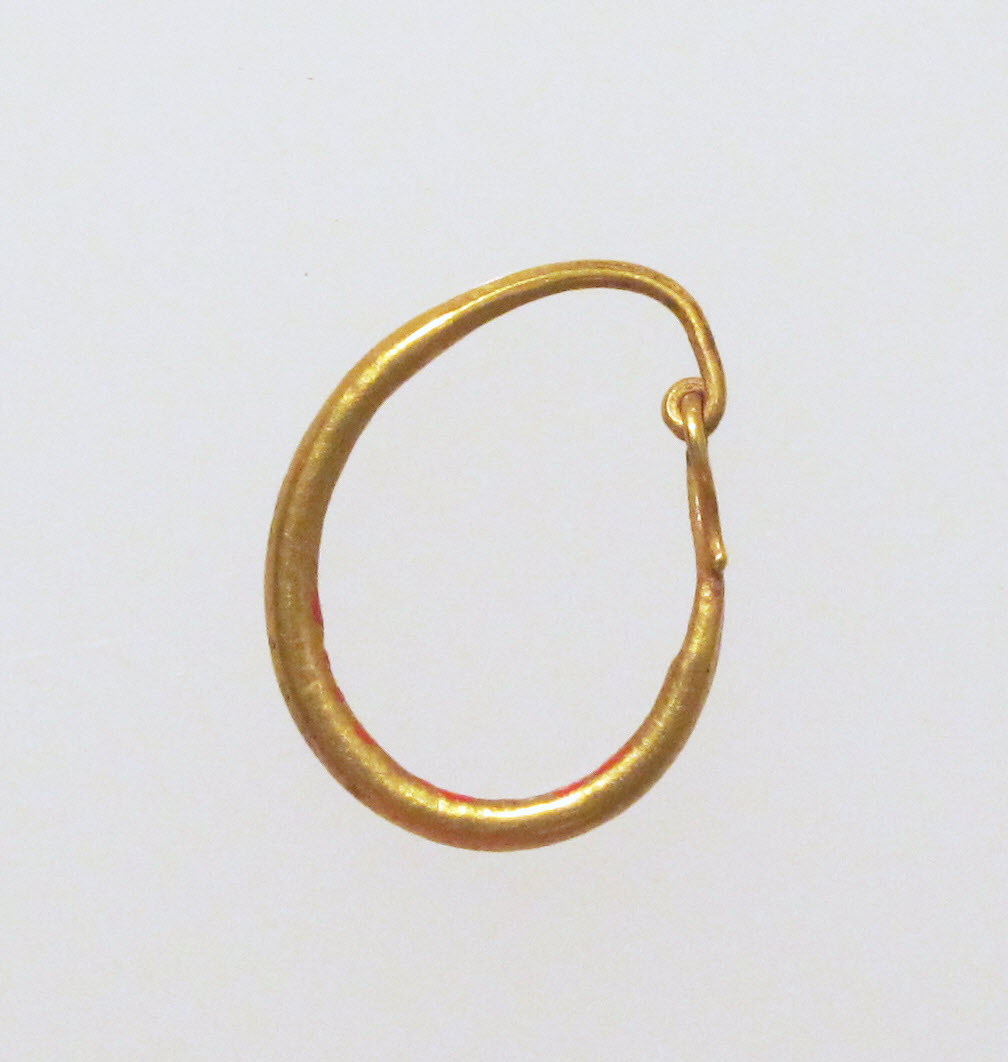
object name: earring loop type, plain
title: Earring-loop type, plain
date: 7000 BCE-330 CE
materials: gold